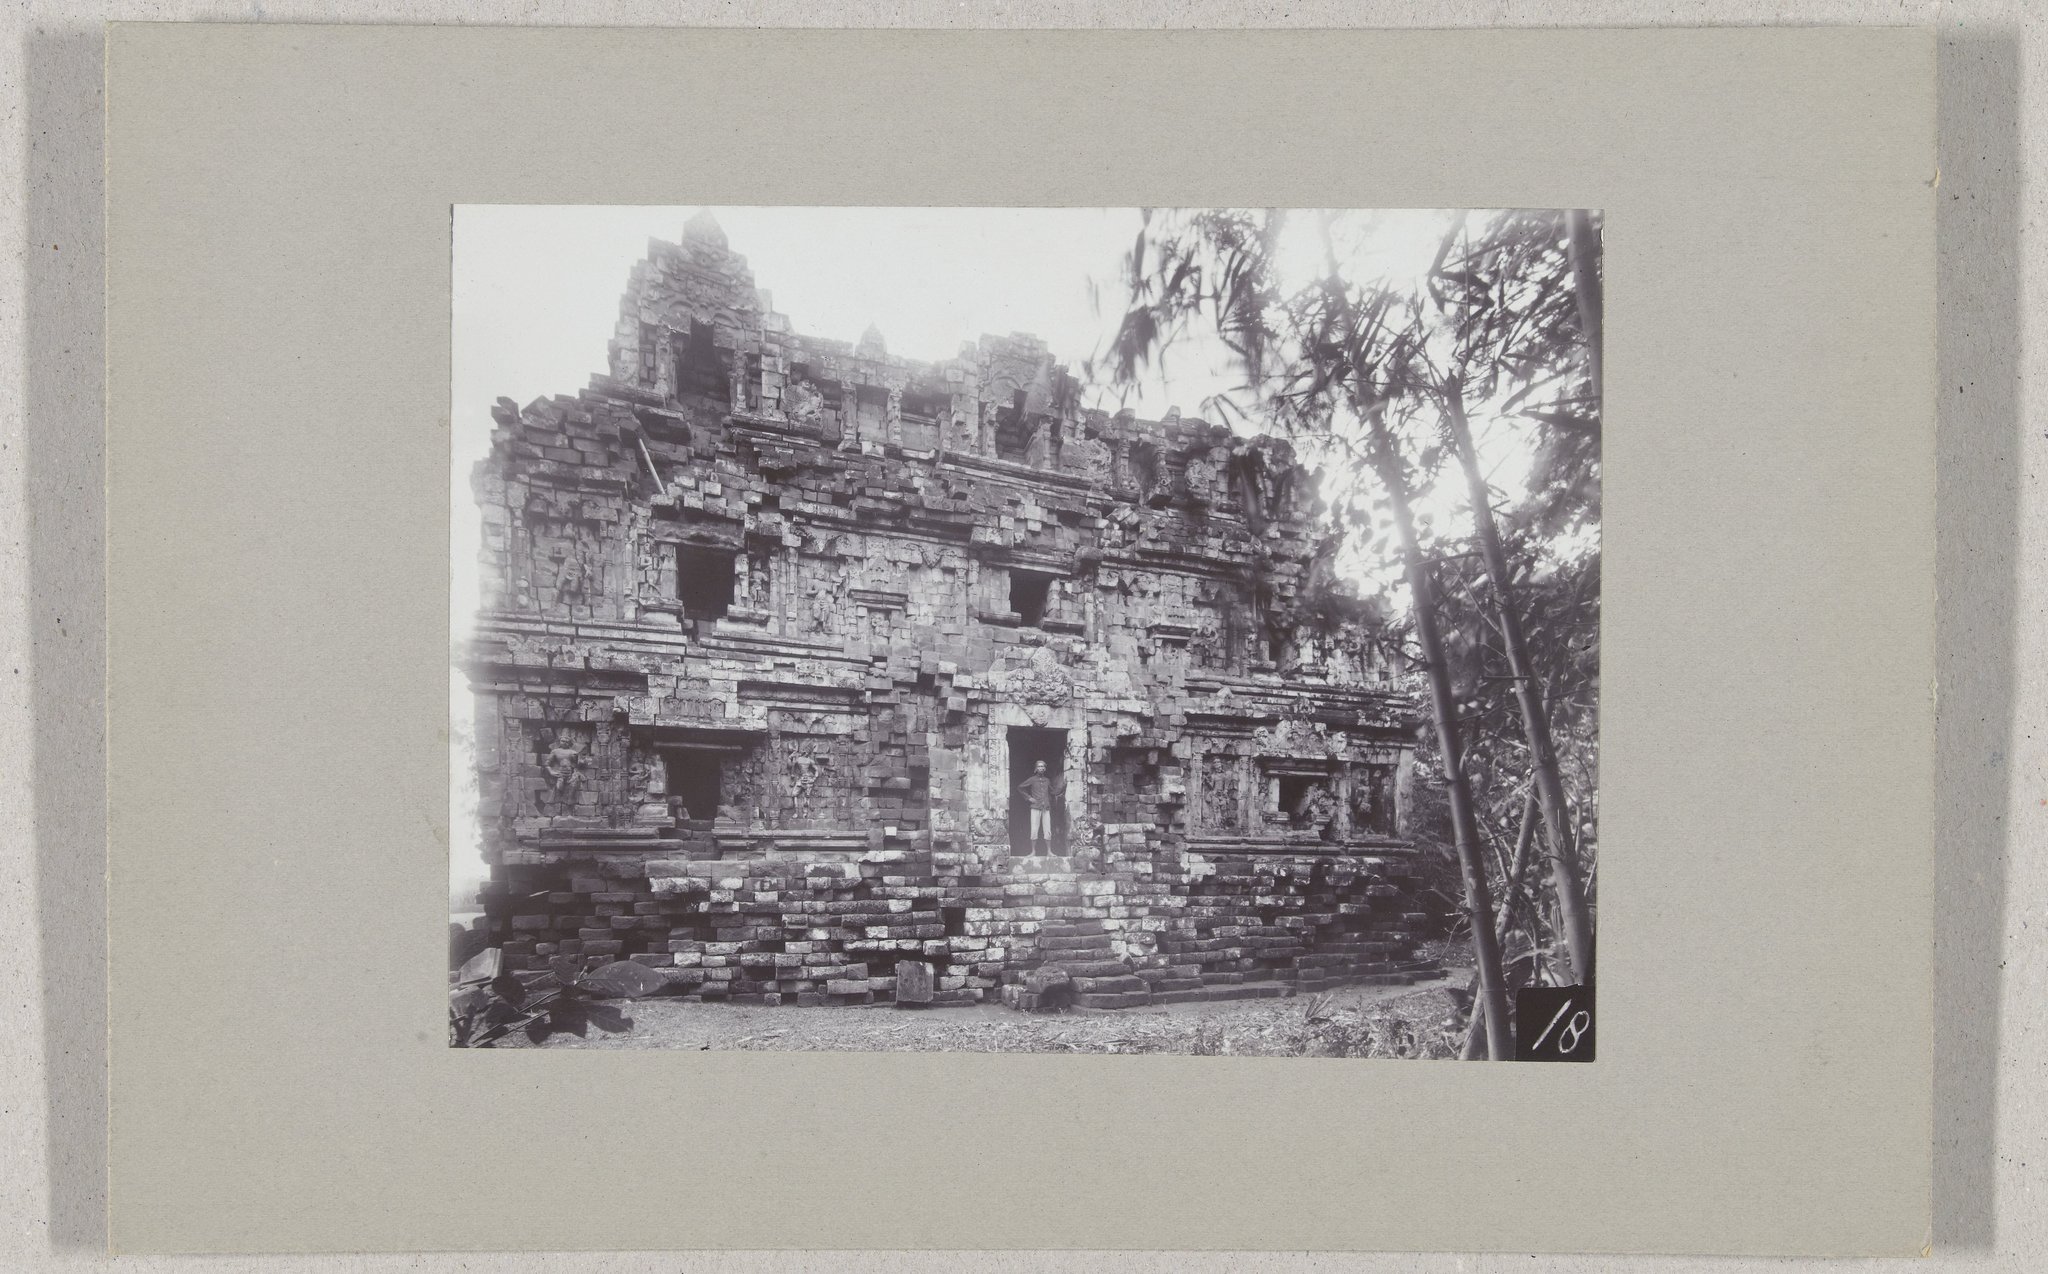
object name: photograph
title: 91a Tjandi Sari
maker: Anonymous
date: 1895-1915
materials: cardboard, paper, photographic support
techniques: gelatin silver print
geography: jogjakarta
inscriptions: number: ‘18’, annotation: ‘91a Tjandi Sari’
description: Tjandi Sari, Prambanan-tempels, bij Jogyakarta, Nederlands-Indië